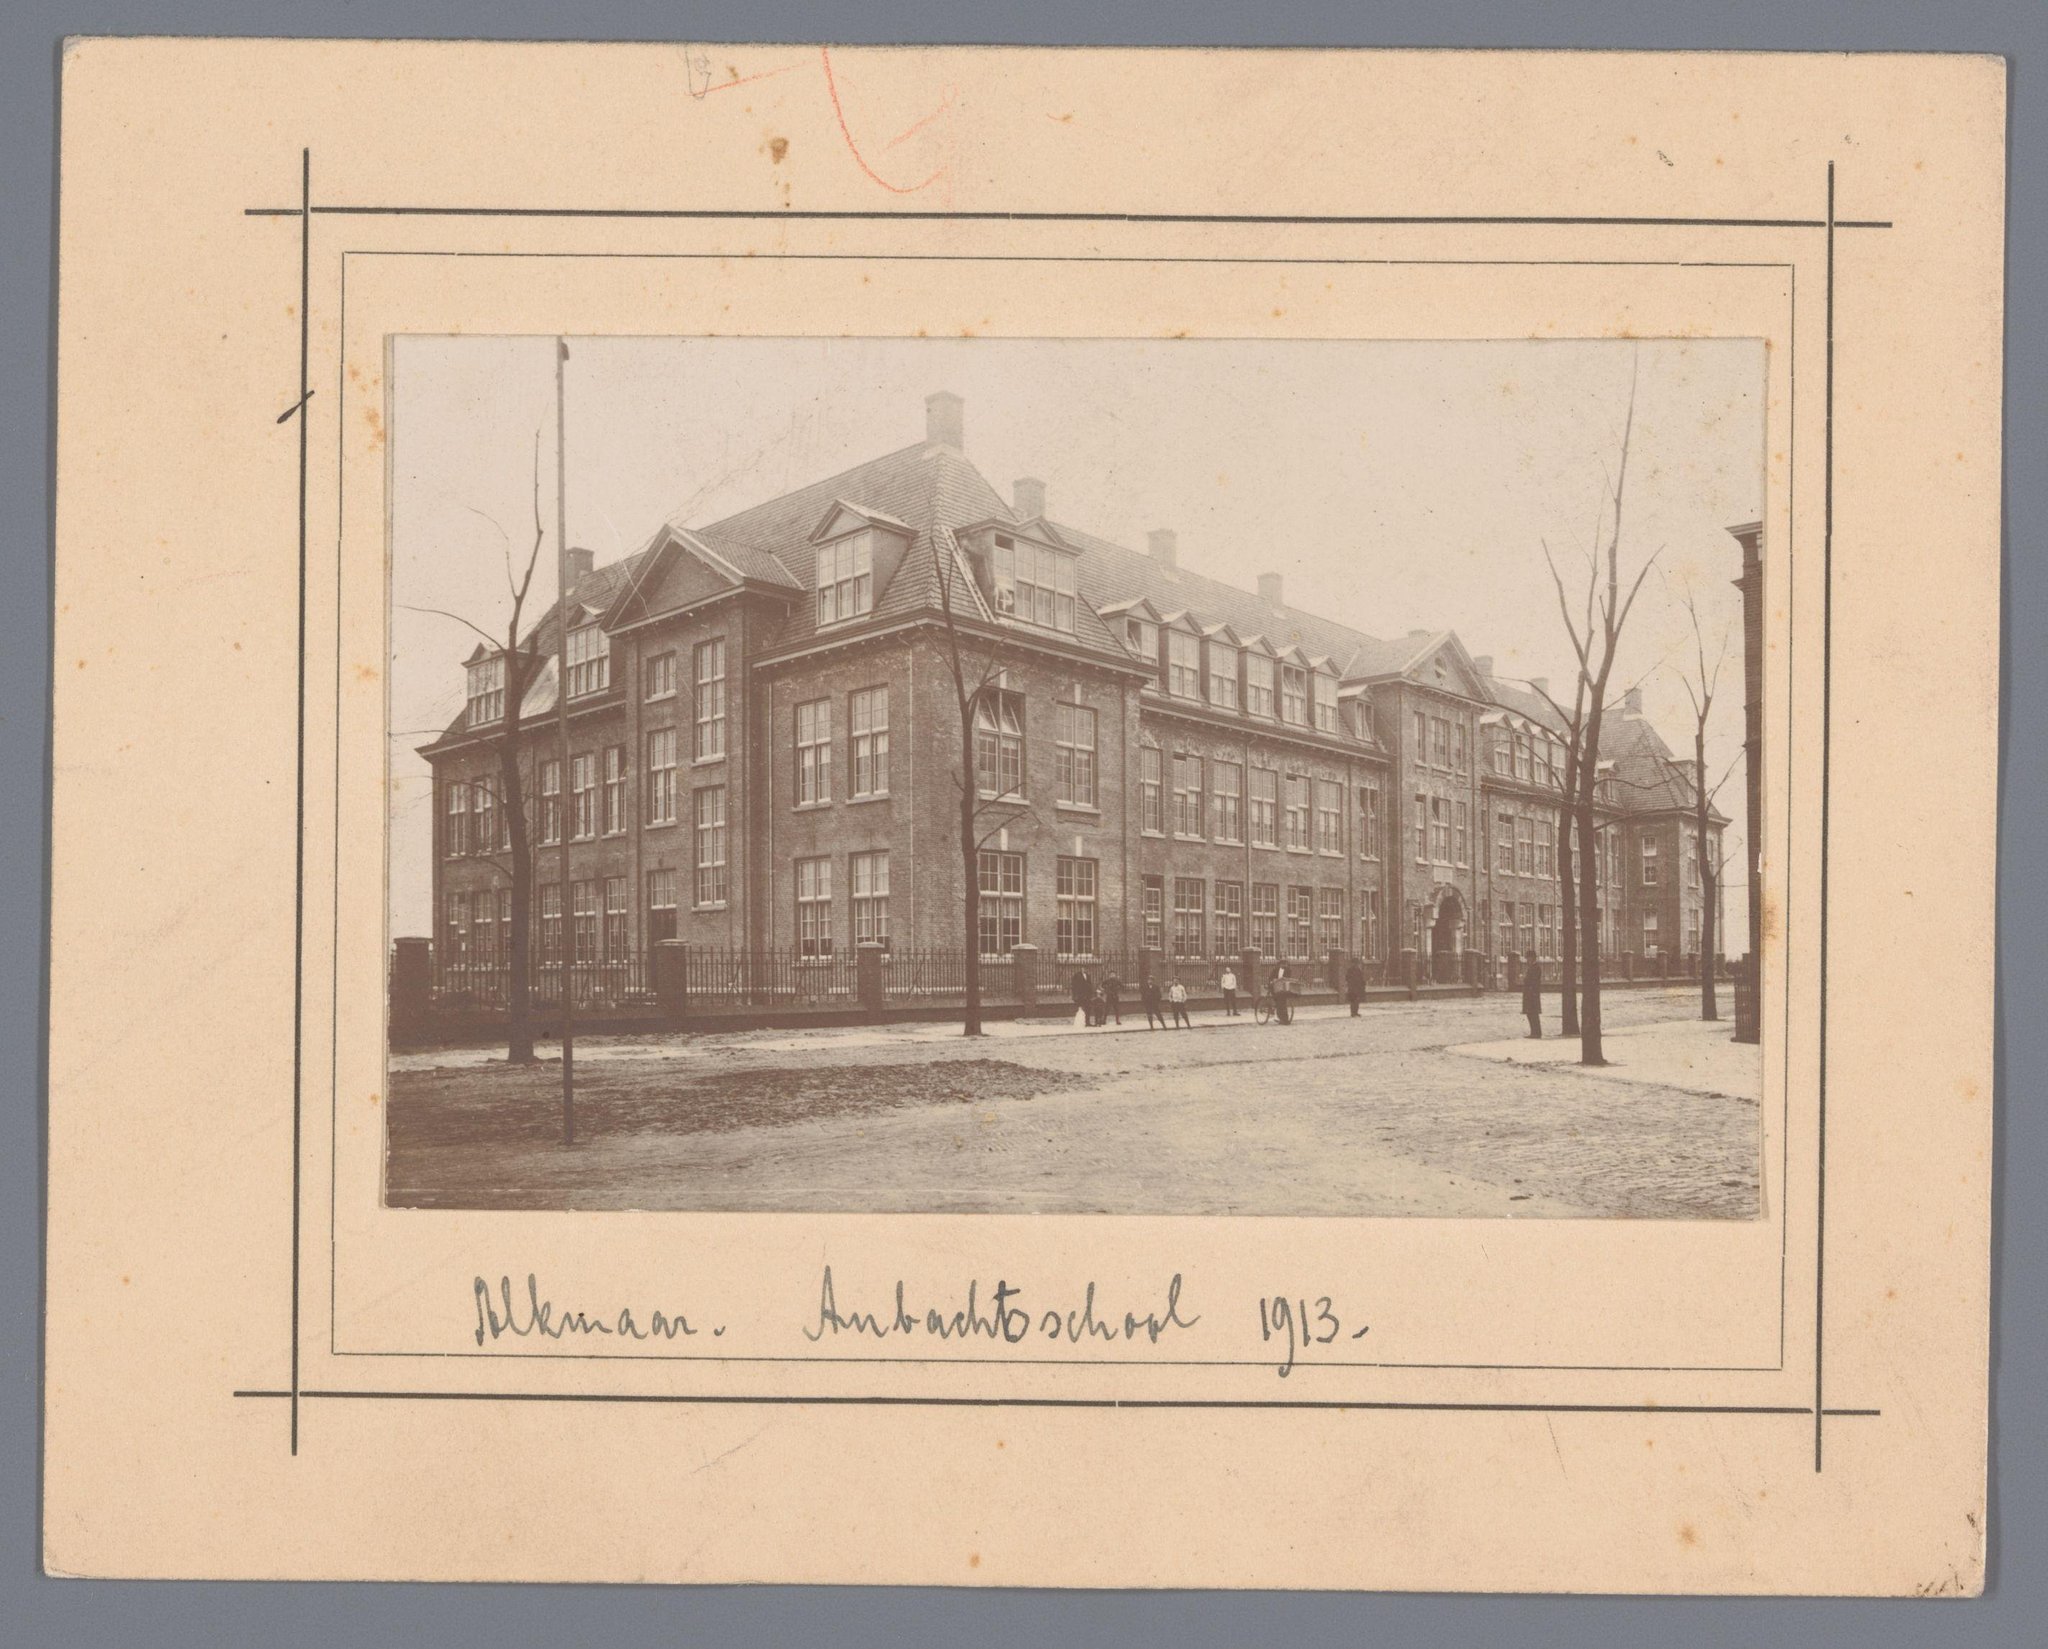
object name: photograph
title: Gezicht op de ambachtsschool te Alkmaar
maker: Anonymous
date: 1913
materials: cardboard, photographic support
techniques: daylight paper print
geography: alkmaar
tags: secondary education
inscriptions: inscription: ‘25 april/ Opening nieuwe Ambachtsschool Alkmaar/ 1913’, annotation: ‘Alkmaar Ambachtsschool 1913’